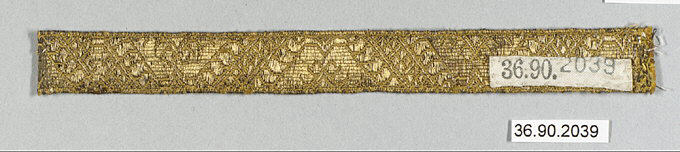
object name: galloon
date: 1801-1900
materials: metal thread